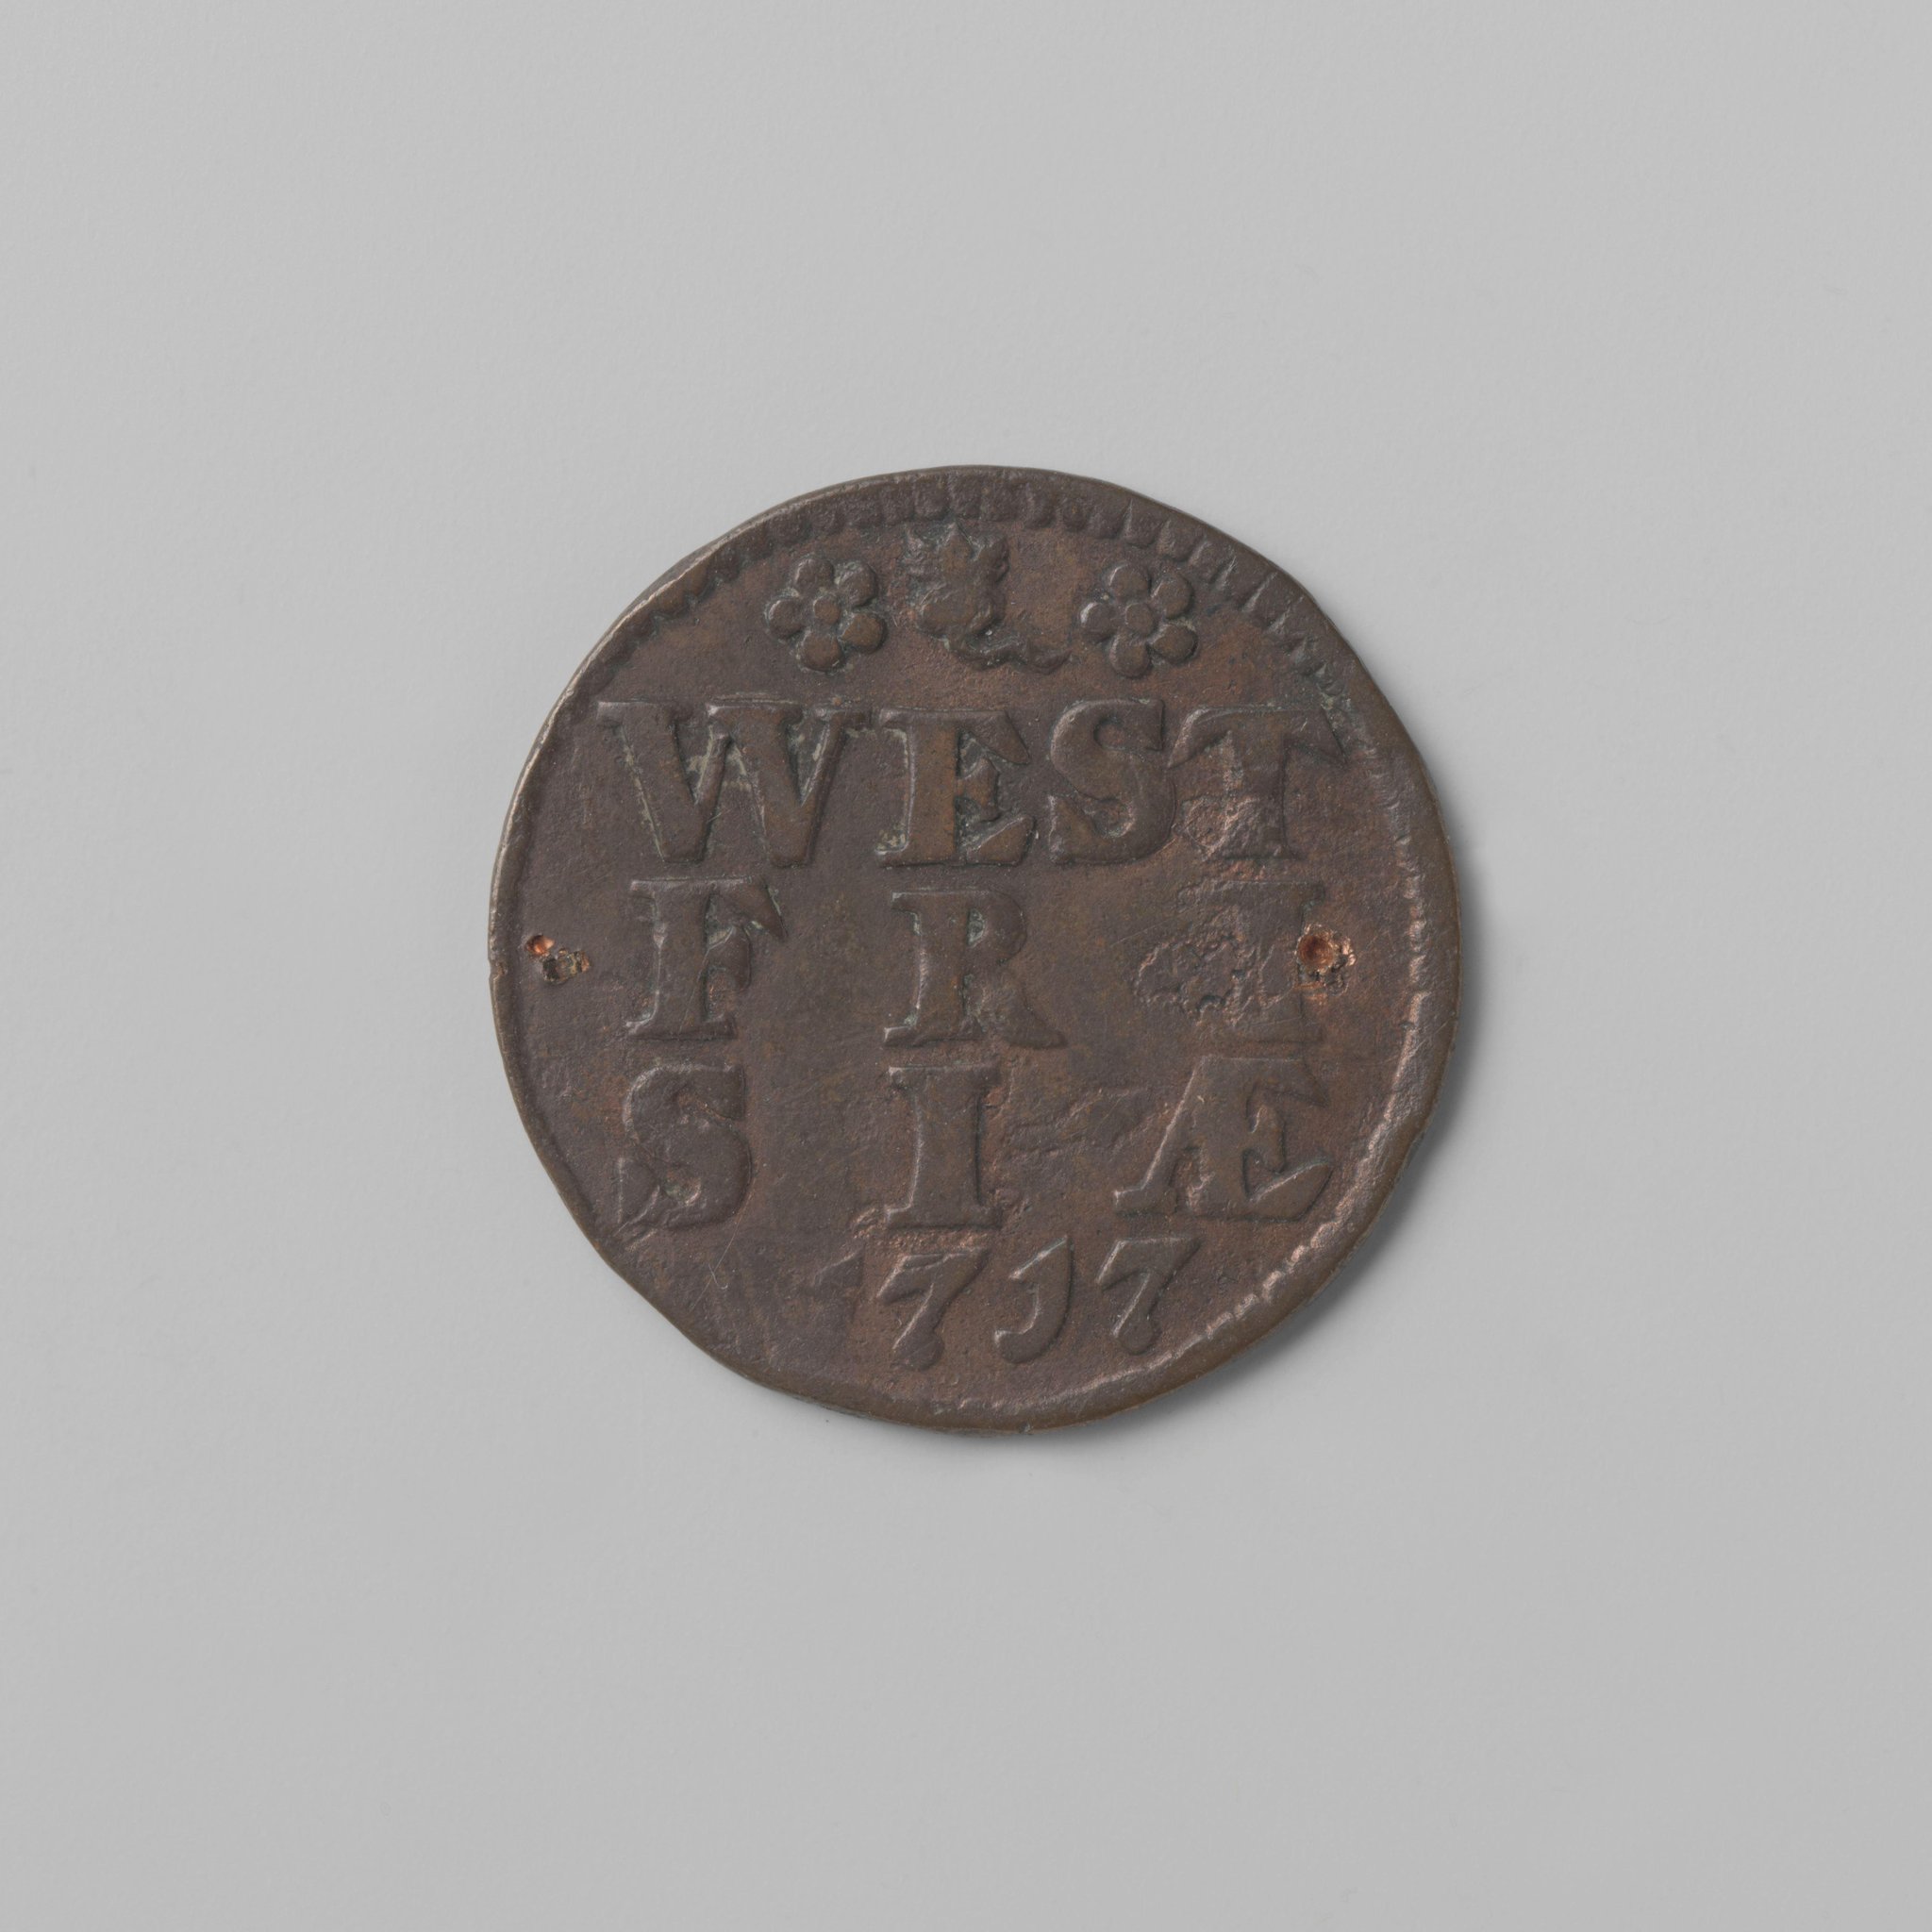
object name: coin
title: Westfriese duit, 1717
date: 1717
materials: copper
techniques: striking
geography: west frisia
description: Koperen munt. Voorzijde: gekroond wapenschild van West-Friesland met lauwertakken. Keerzijde: opschrift in drie regels. Daarboven muntmeesterteken knol tussen twee rozetten. Daaronder jaartal.